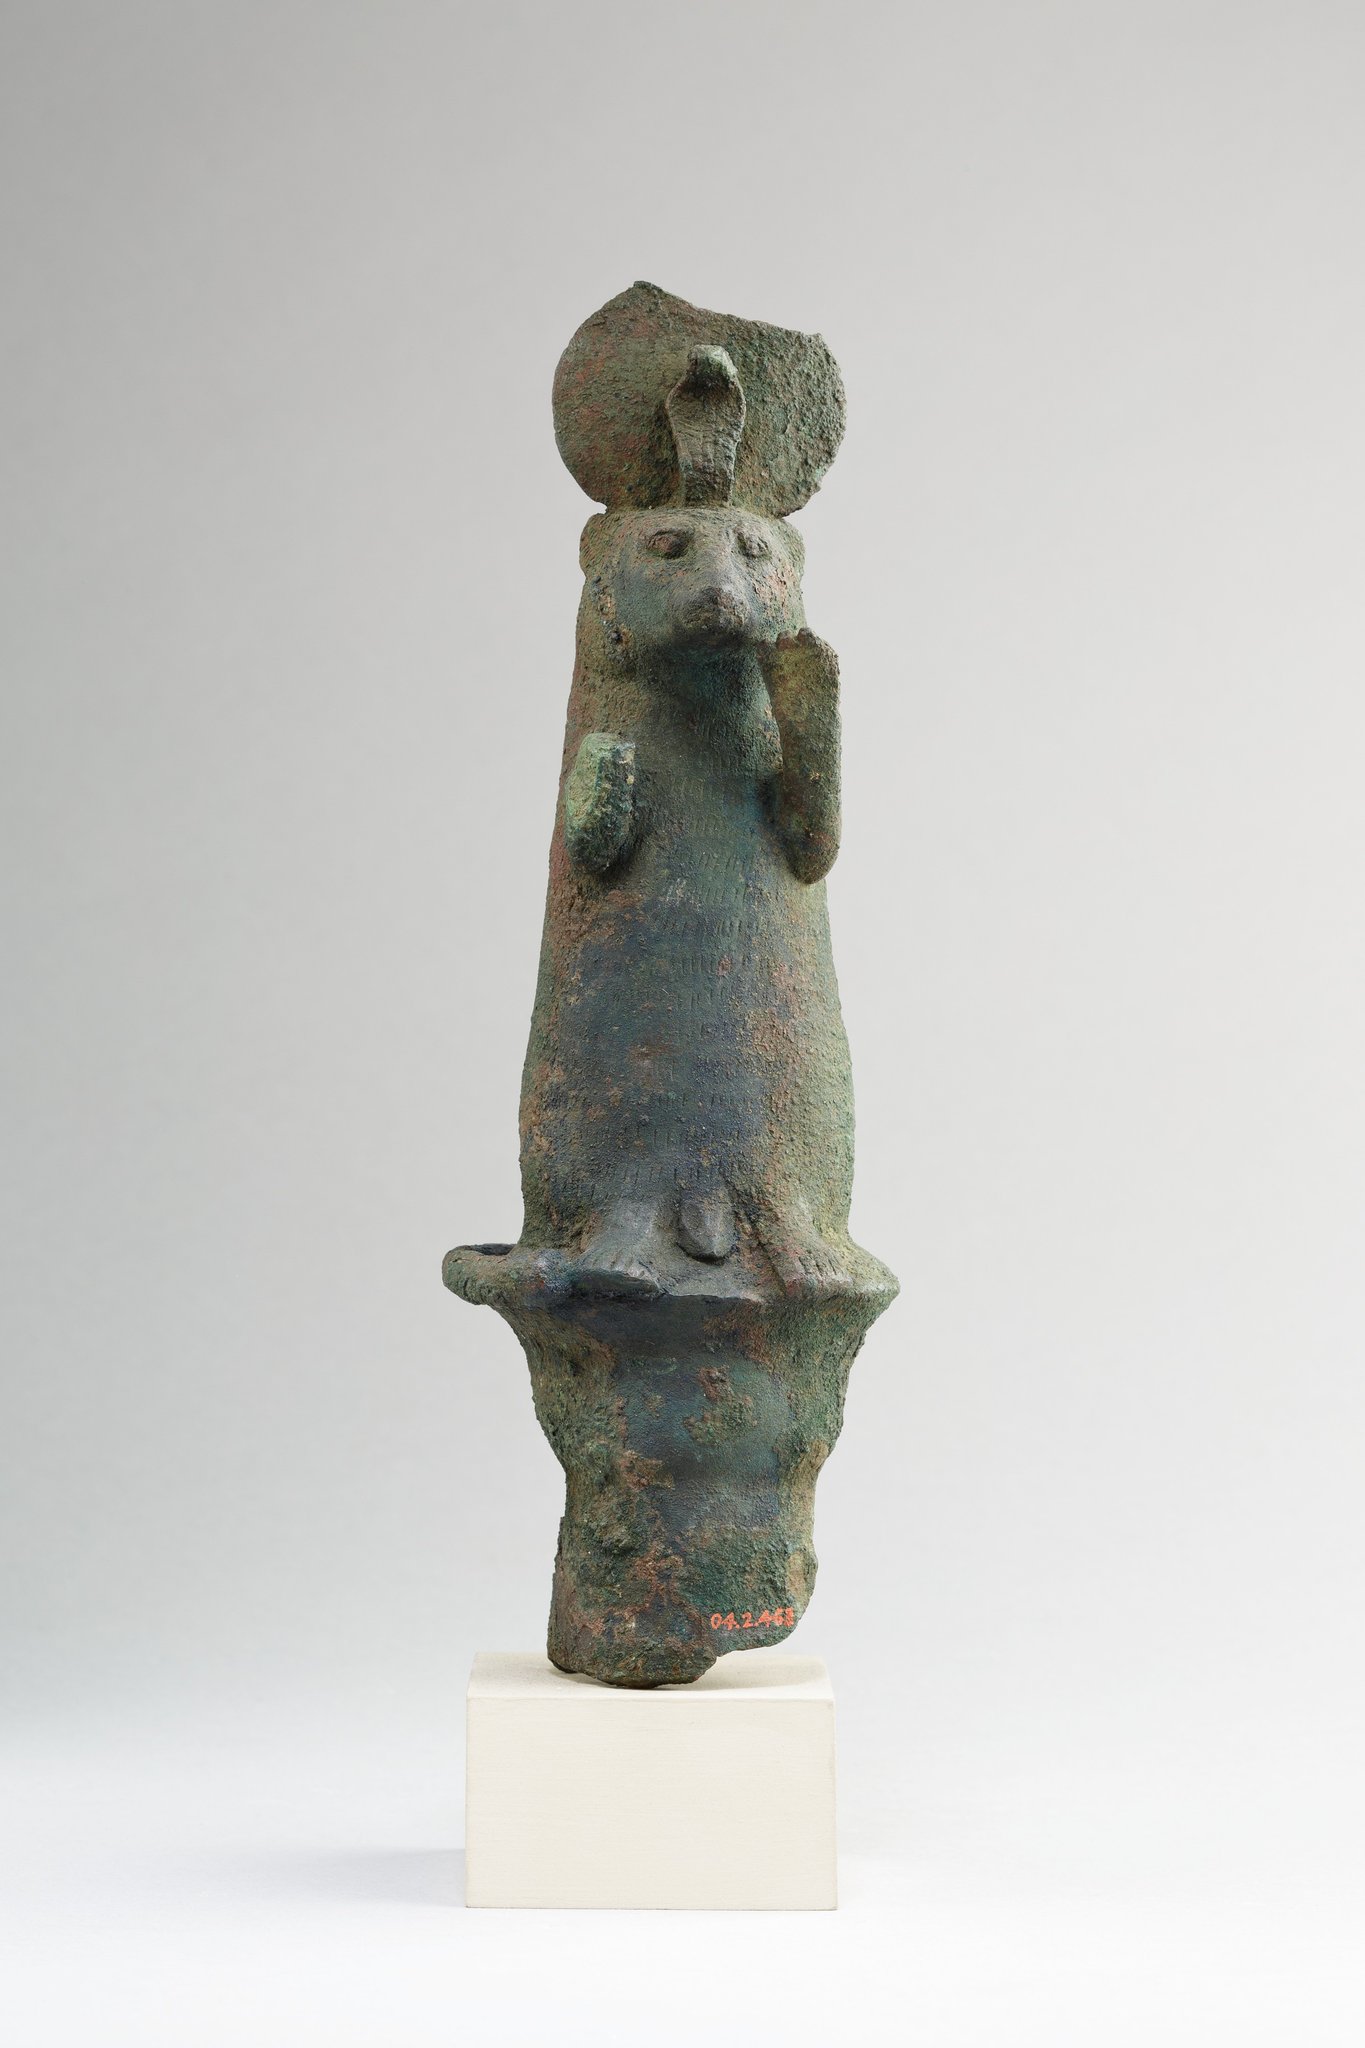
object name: figurine, ichneumon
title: Mongoose (ichneumon) on a papyrus-shaped pillar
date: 664-630 BCE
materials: bronze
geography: egypt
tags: animals